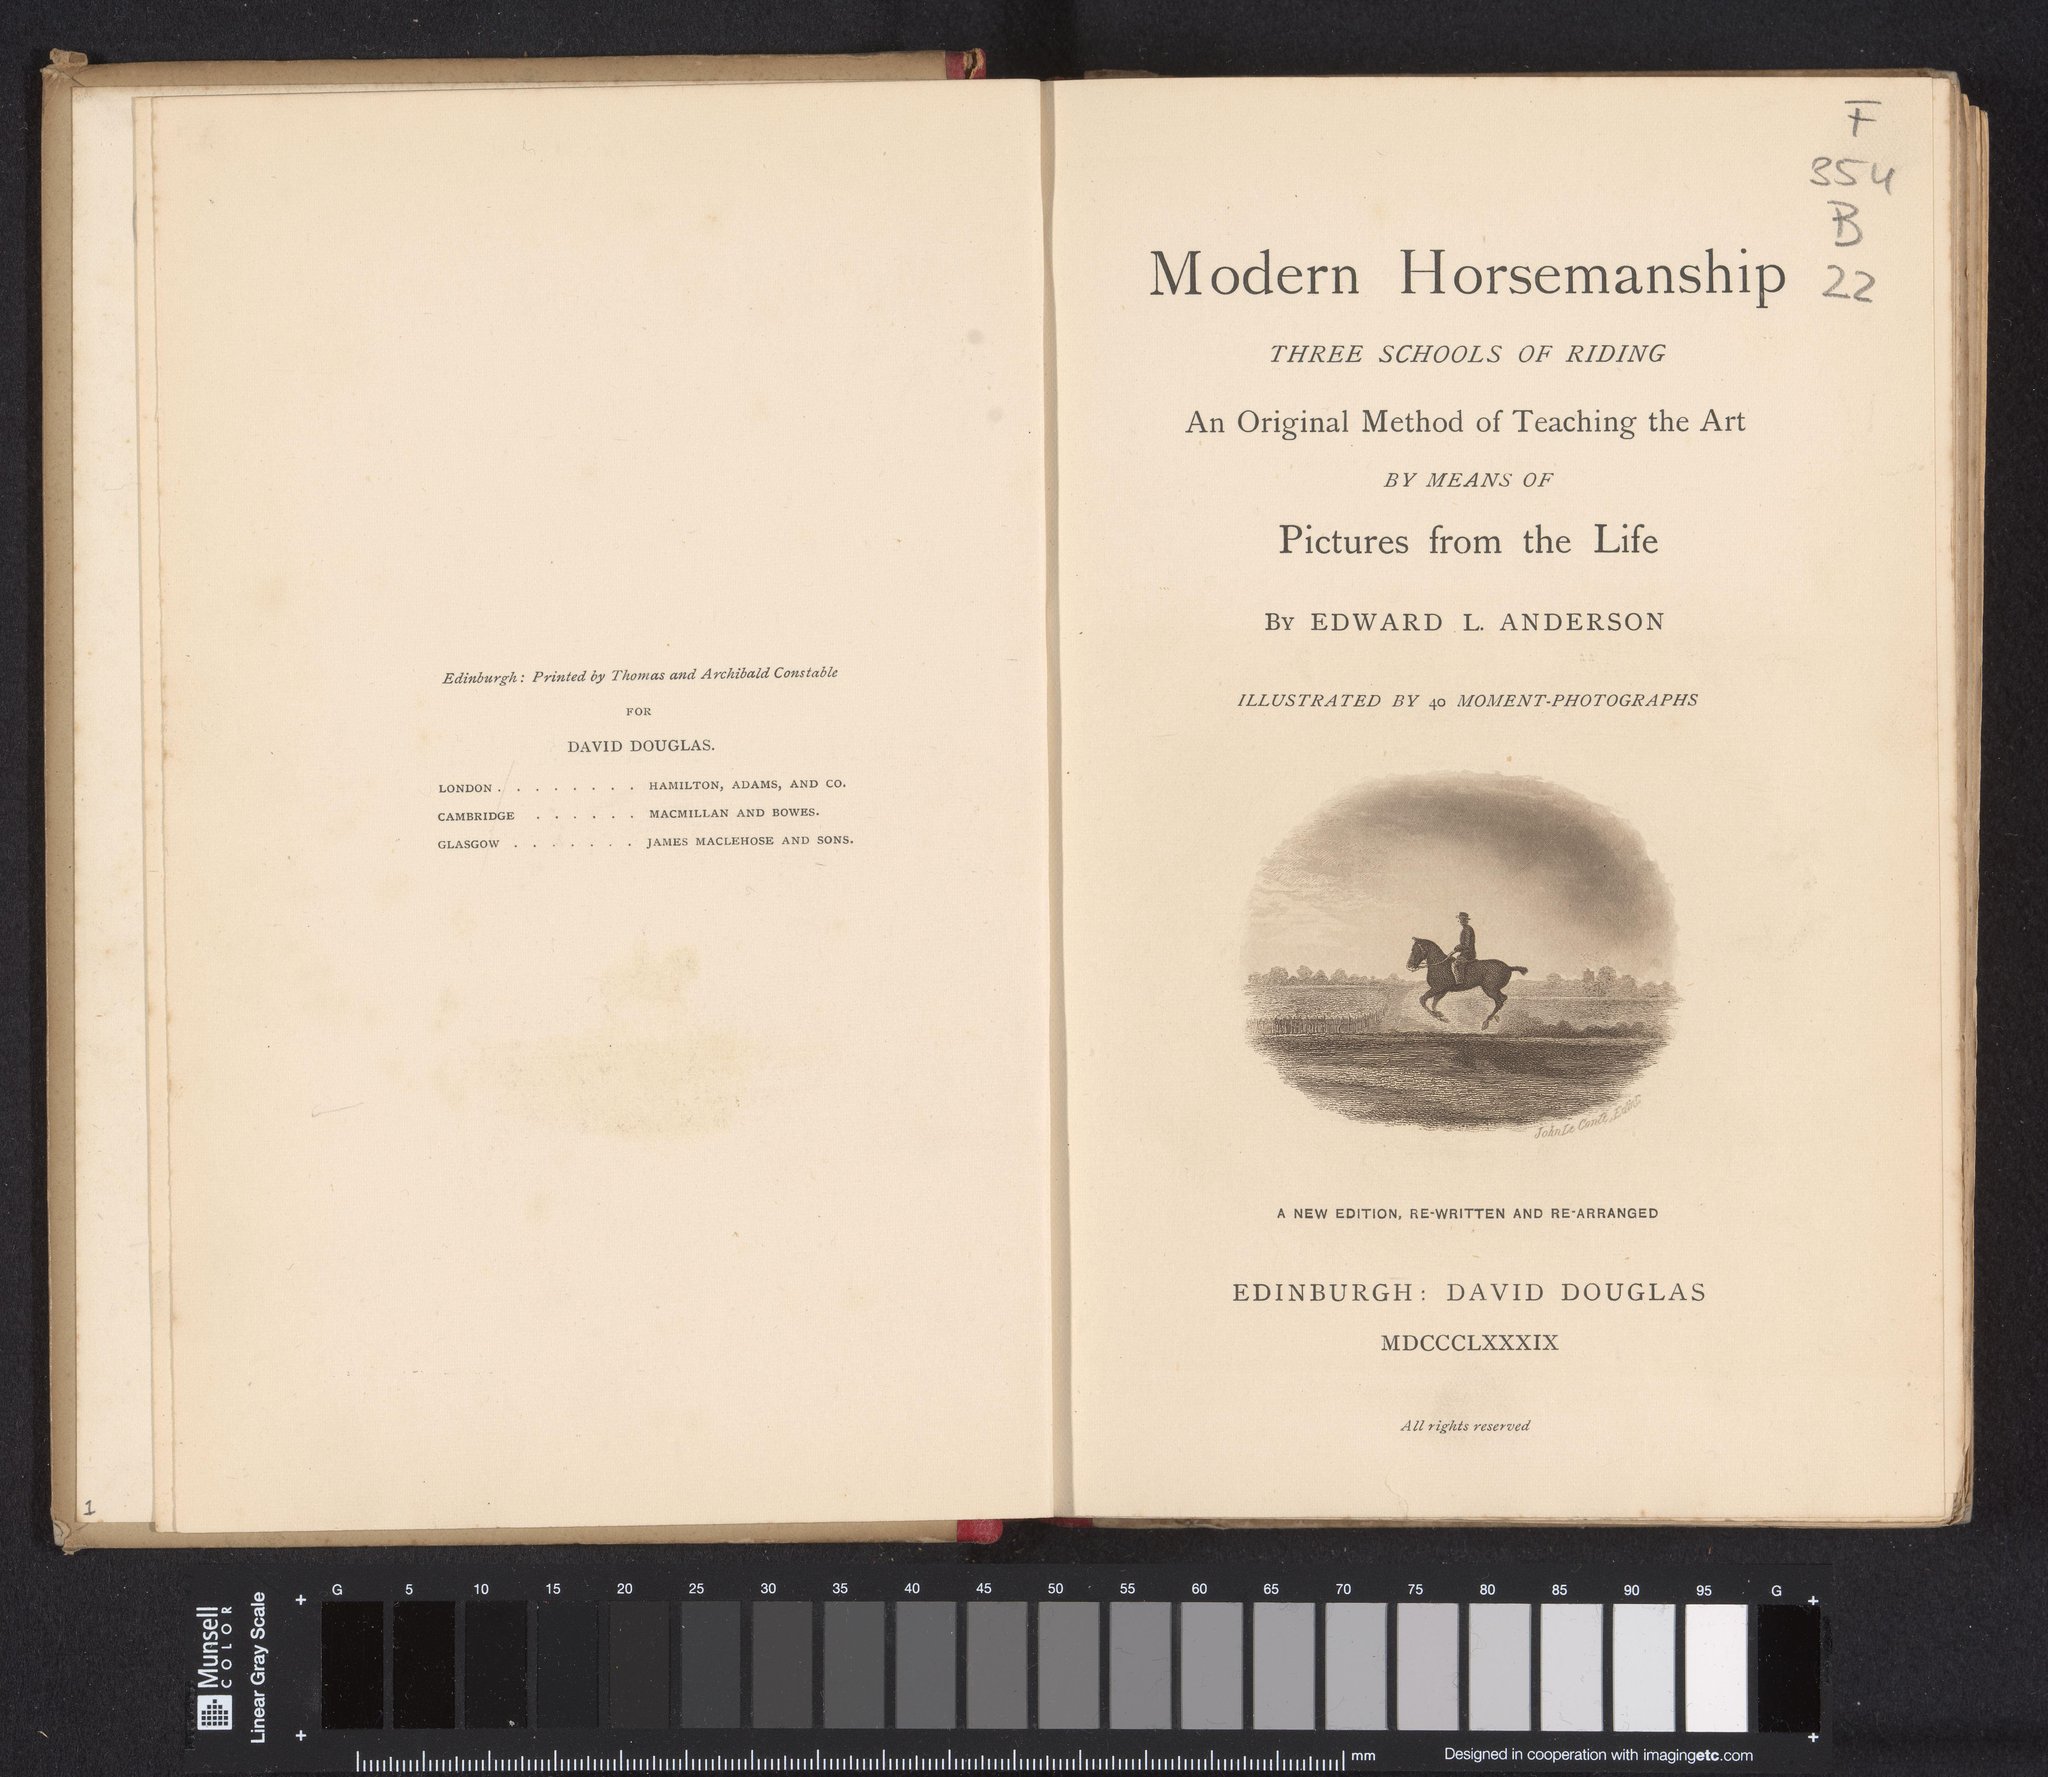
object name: book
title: Modern horsemanship three schools of riding an original method of teaching the art by means of pictures from the life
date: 1889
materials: cardboard, leather, paper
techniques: photograph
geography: edinburgh